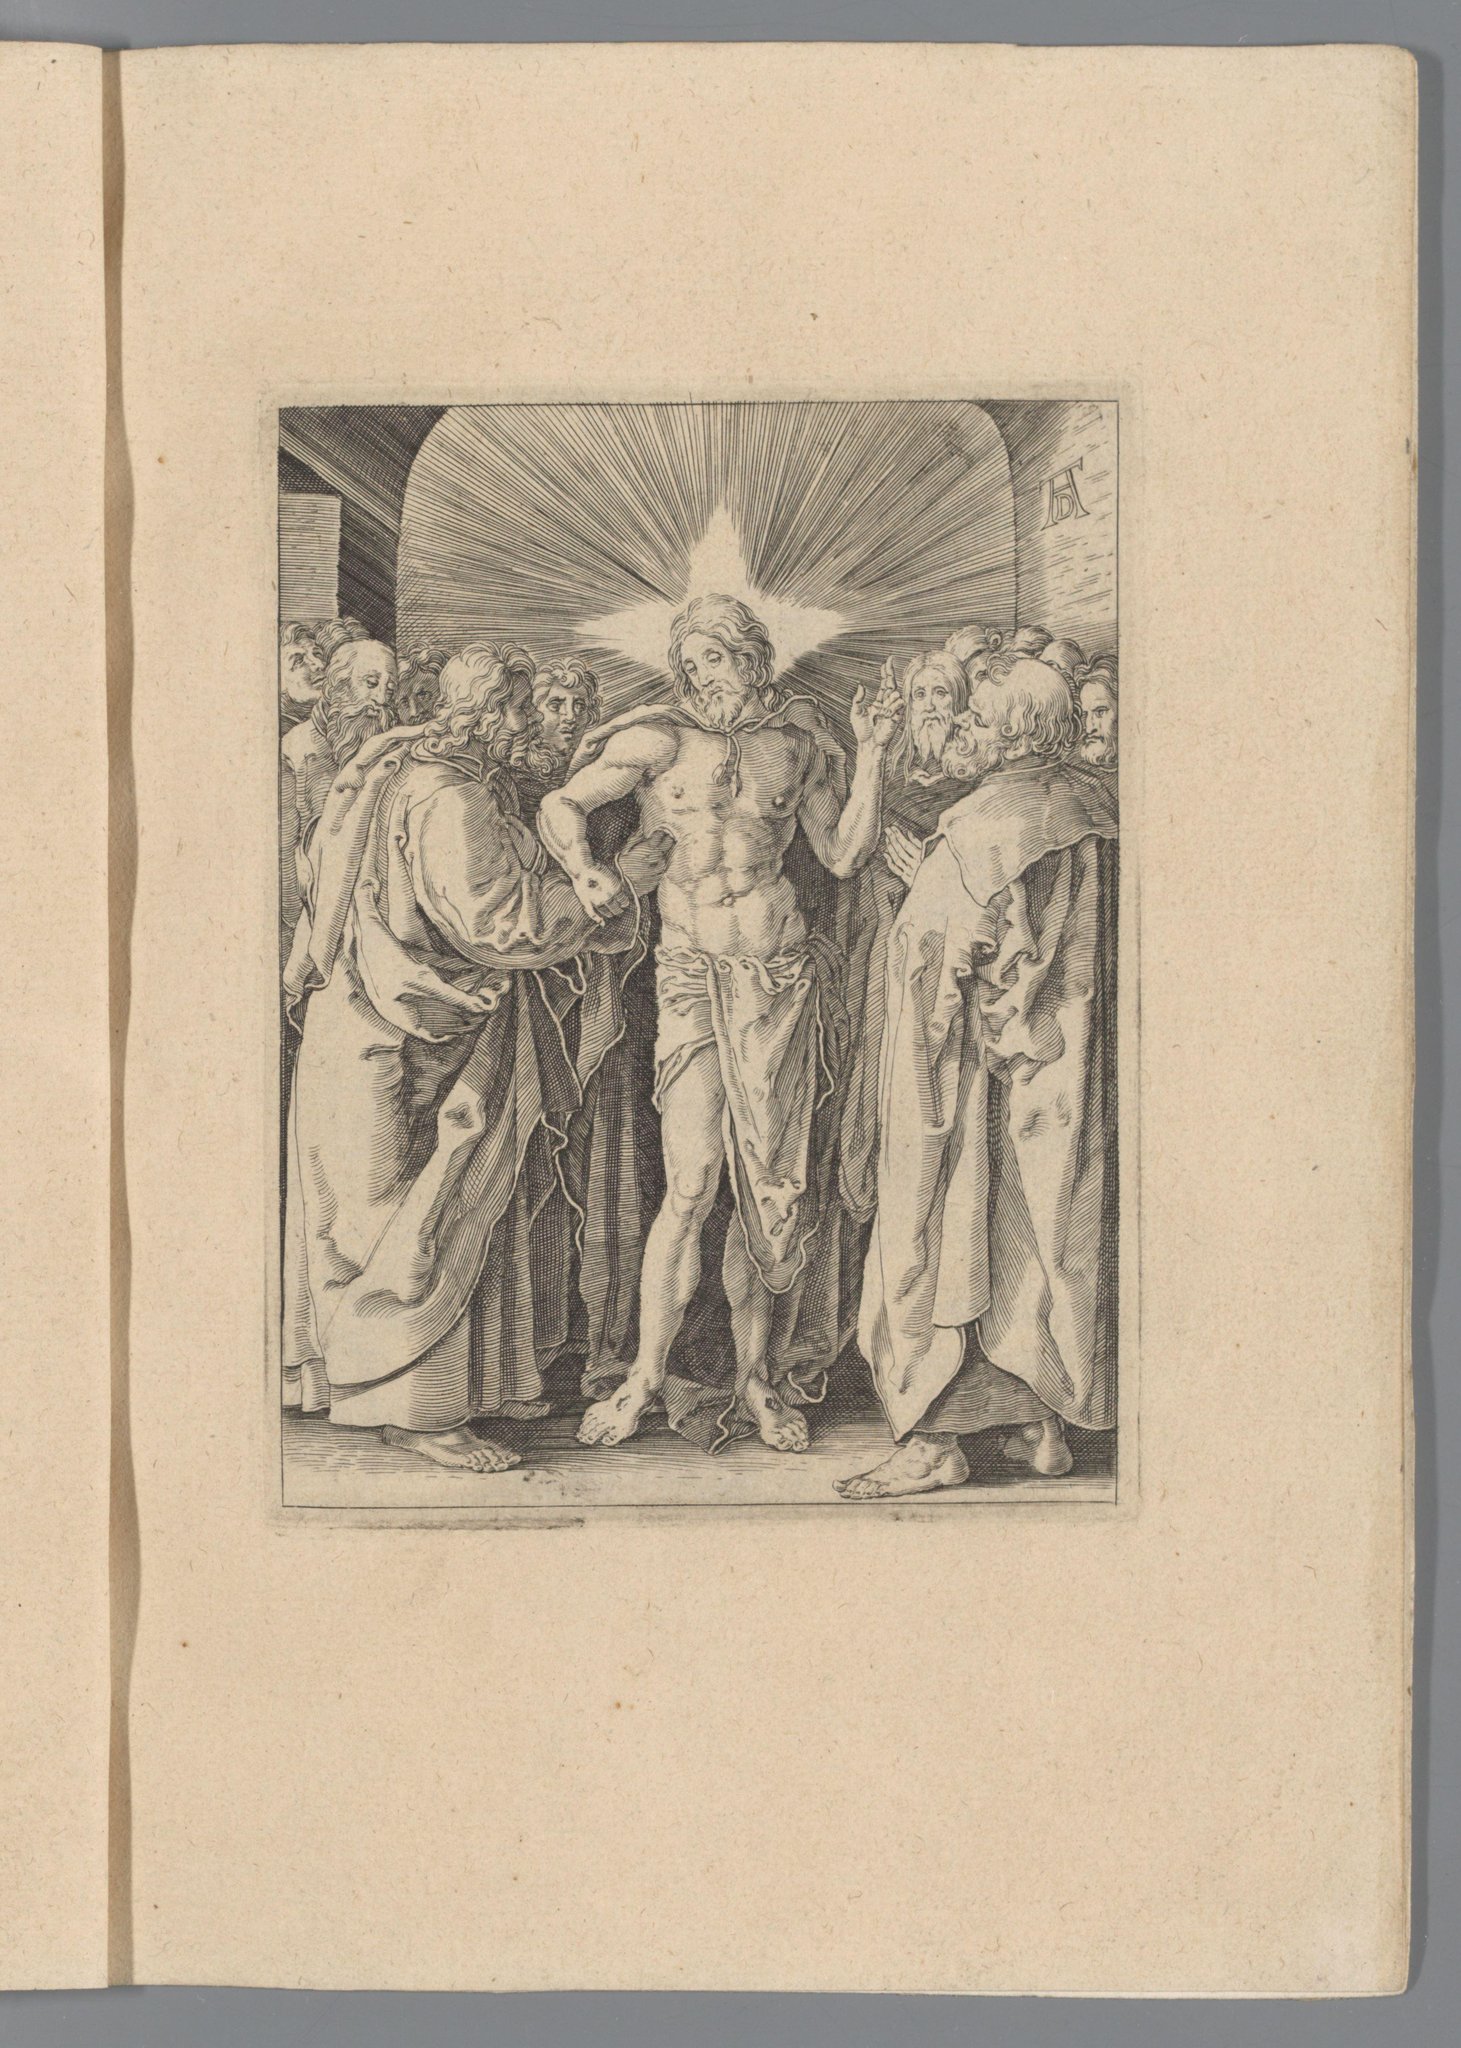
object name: album leaf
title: Ongelovige Tomas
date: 1610-1620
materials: paper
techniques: engraving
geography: the hague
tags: thomas touching or stretching out his hands to touch the wound in christ's side, sometimes christ leading thomas' hand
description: De discipel Tomas voelt aan de zijdewond van Christus, omringd door de andere discipelen. Prent maakt deel uit van een album.